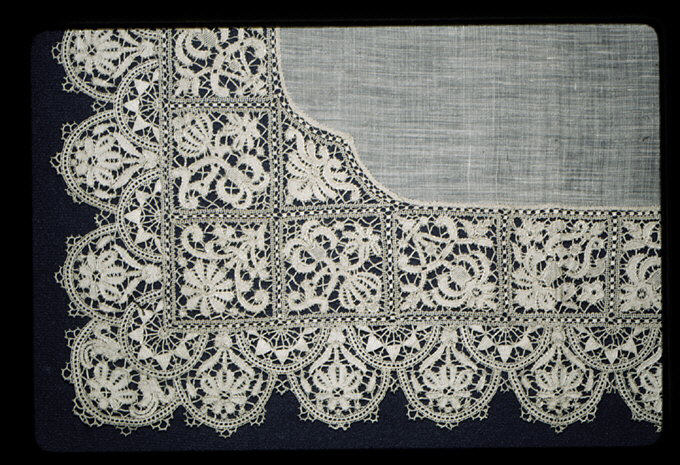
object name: handkerchief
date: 1801-1900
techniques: lace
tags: flowers